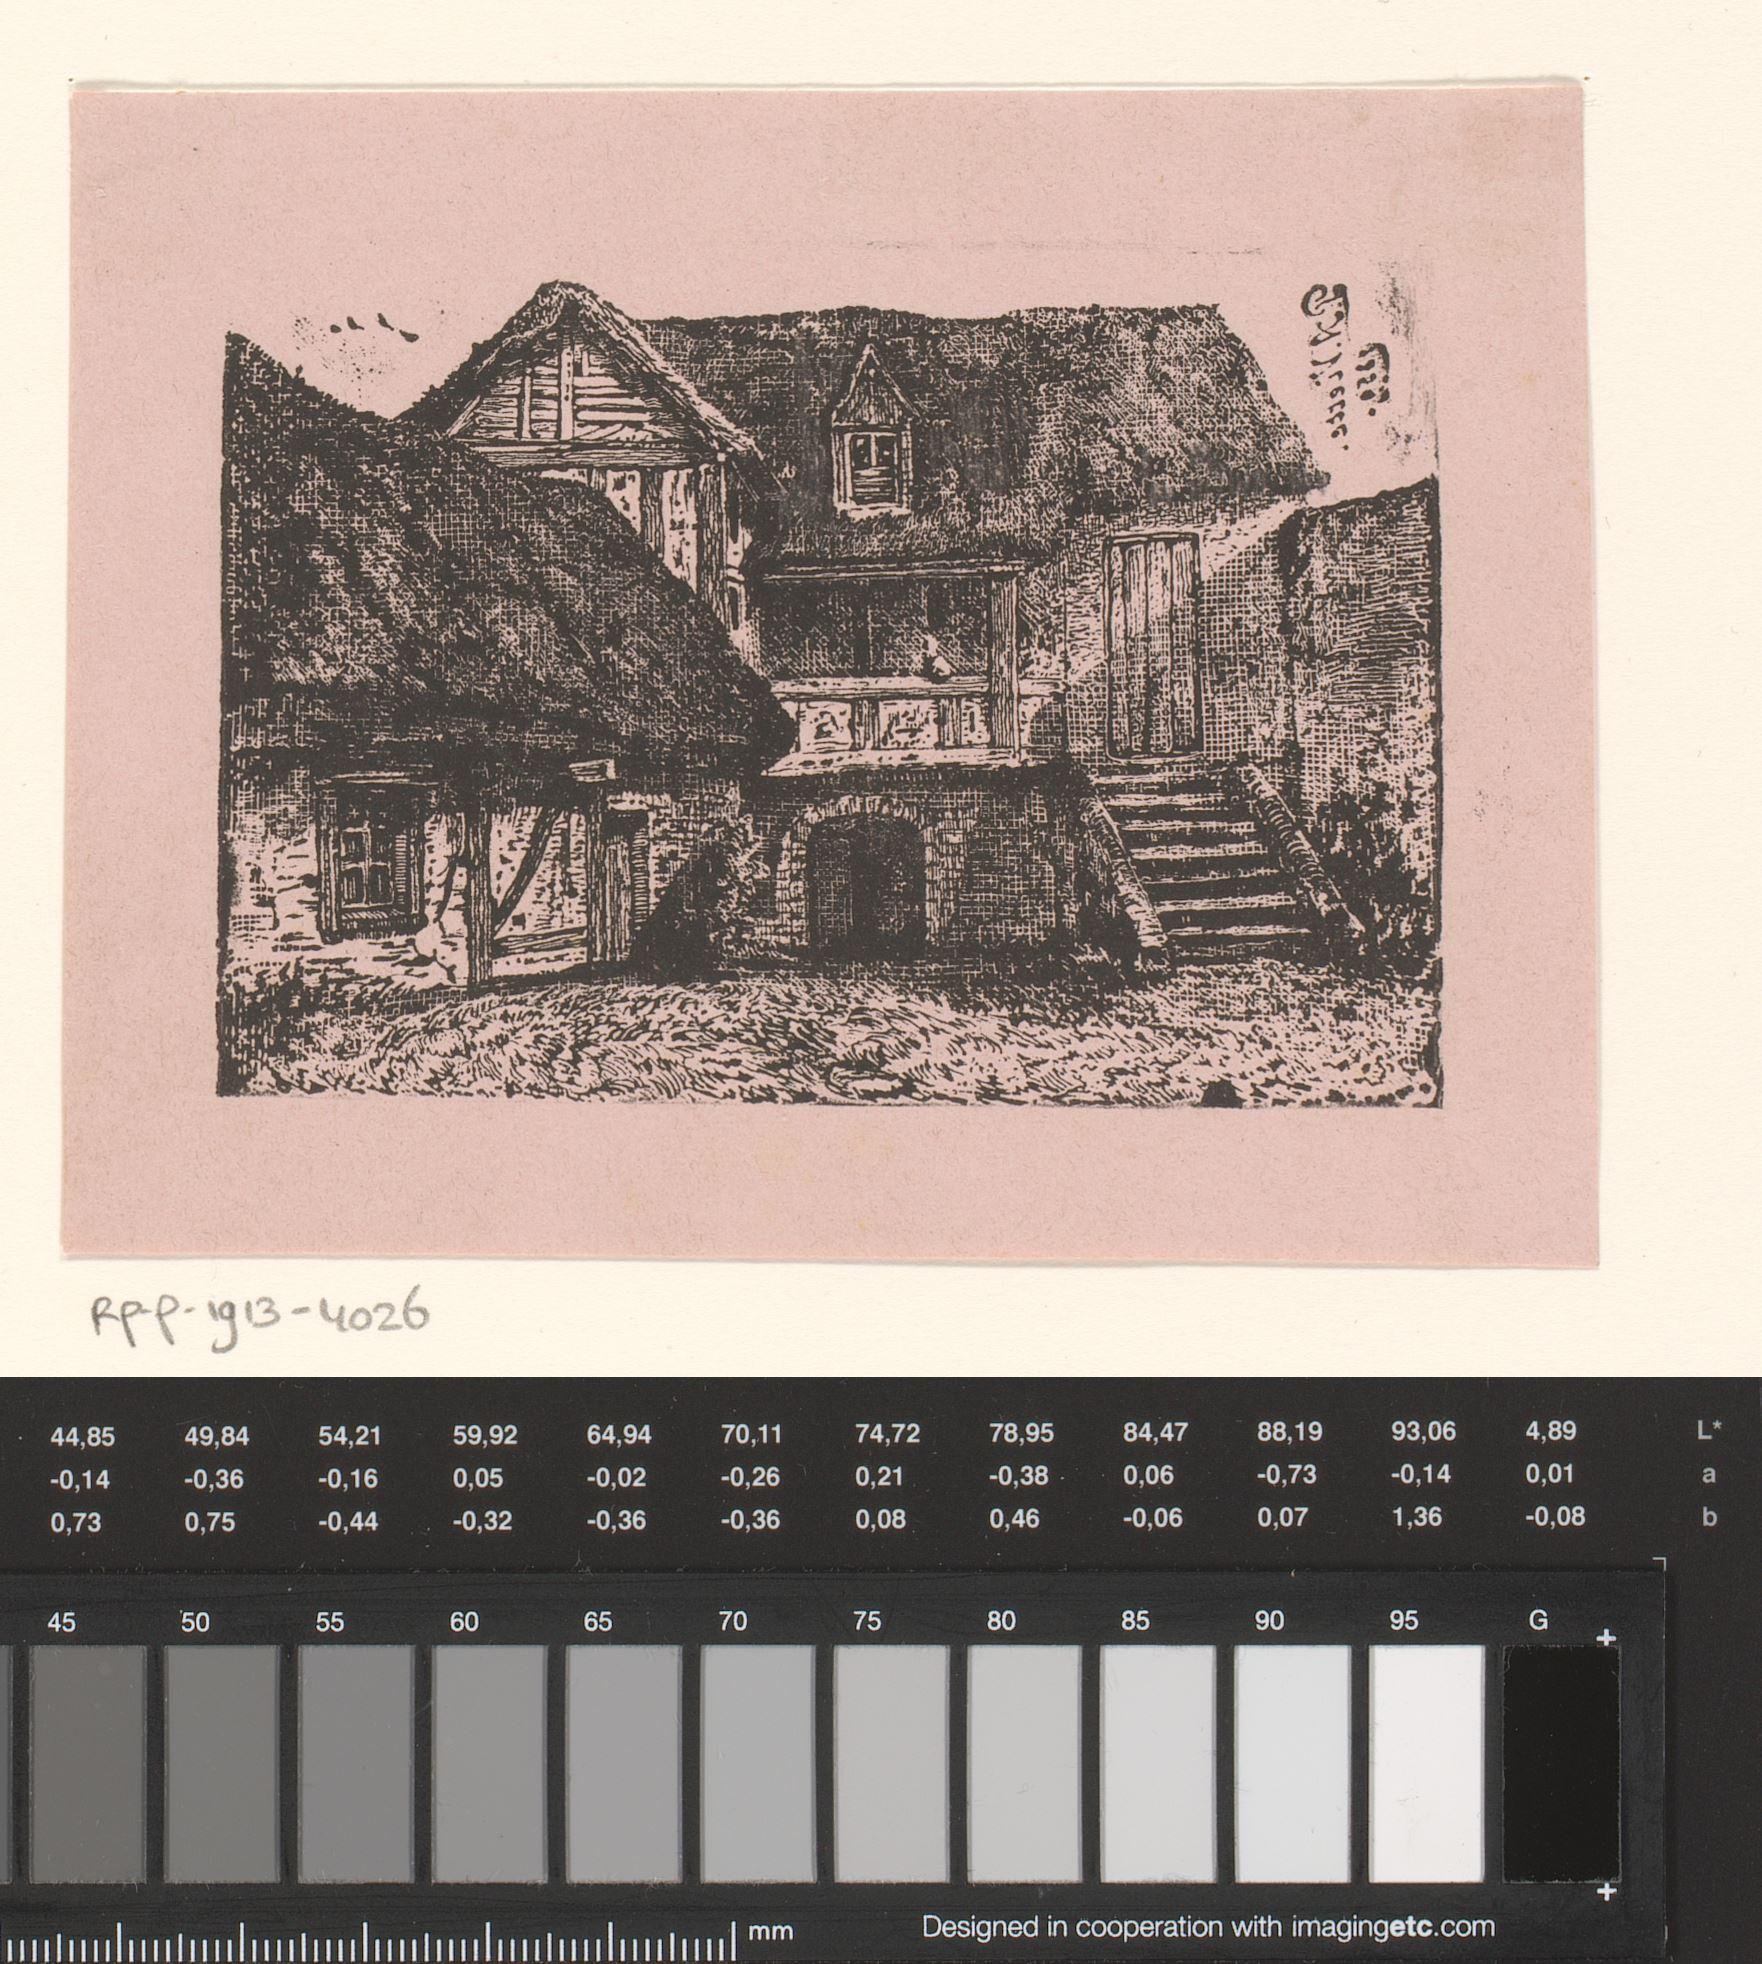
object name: print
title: Boerenwoning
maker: polynice auguste viette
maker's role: print maker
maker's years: 1814-1891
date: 1859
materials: paper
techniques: engraving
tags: courtyard, farm (building)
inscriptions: collector's mark: Lugt 2228, collector's mark: Lugt 1485